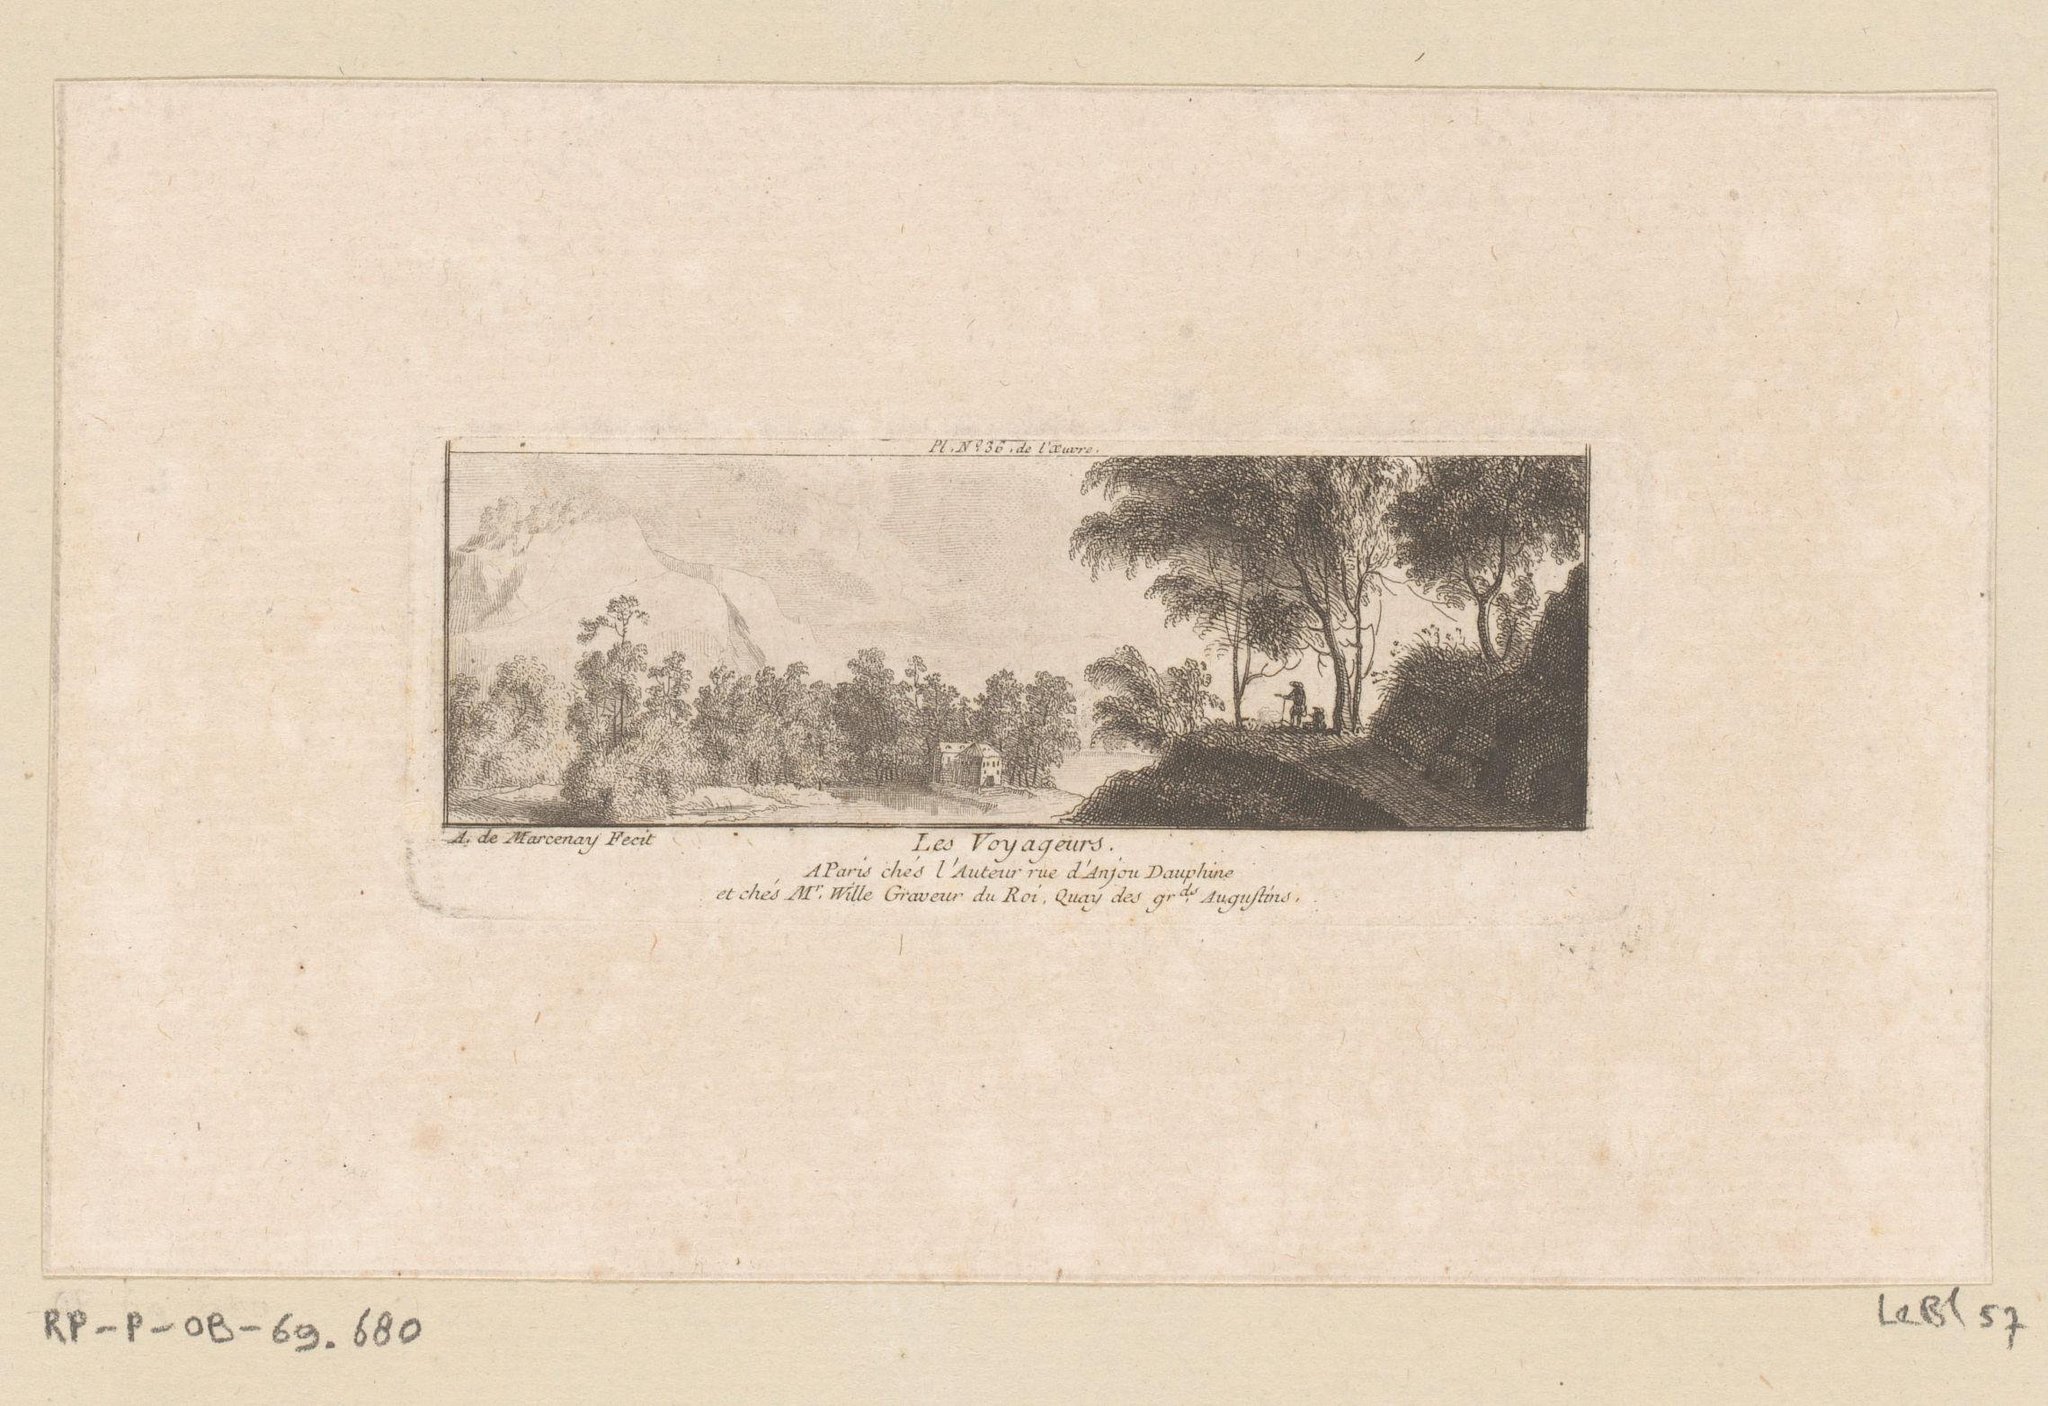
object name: print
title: Les Voyageurs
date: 1734-1811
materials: paper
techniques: etching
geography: paris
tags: 'en route', traveller under way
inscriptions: collector's mark: Lugt 2228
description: Genummerd midden boven: Pl. No. 36 de l'Oeuvre.